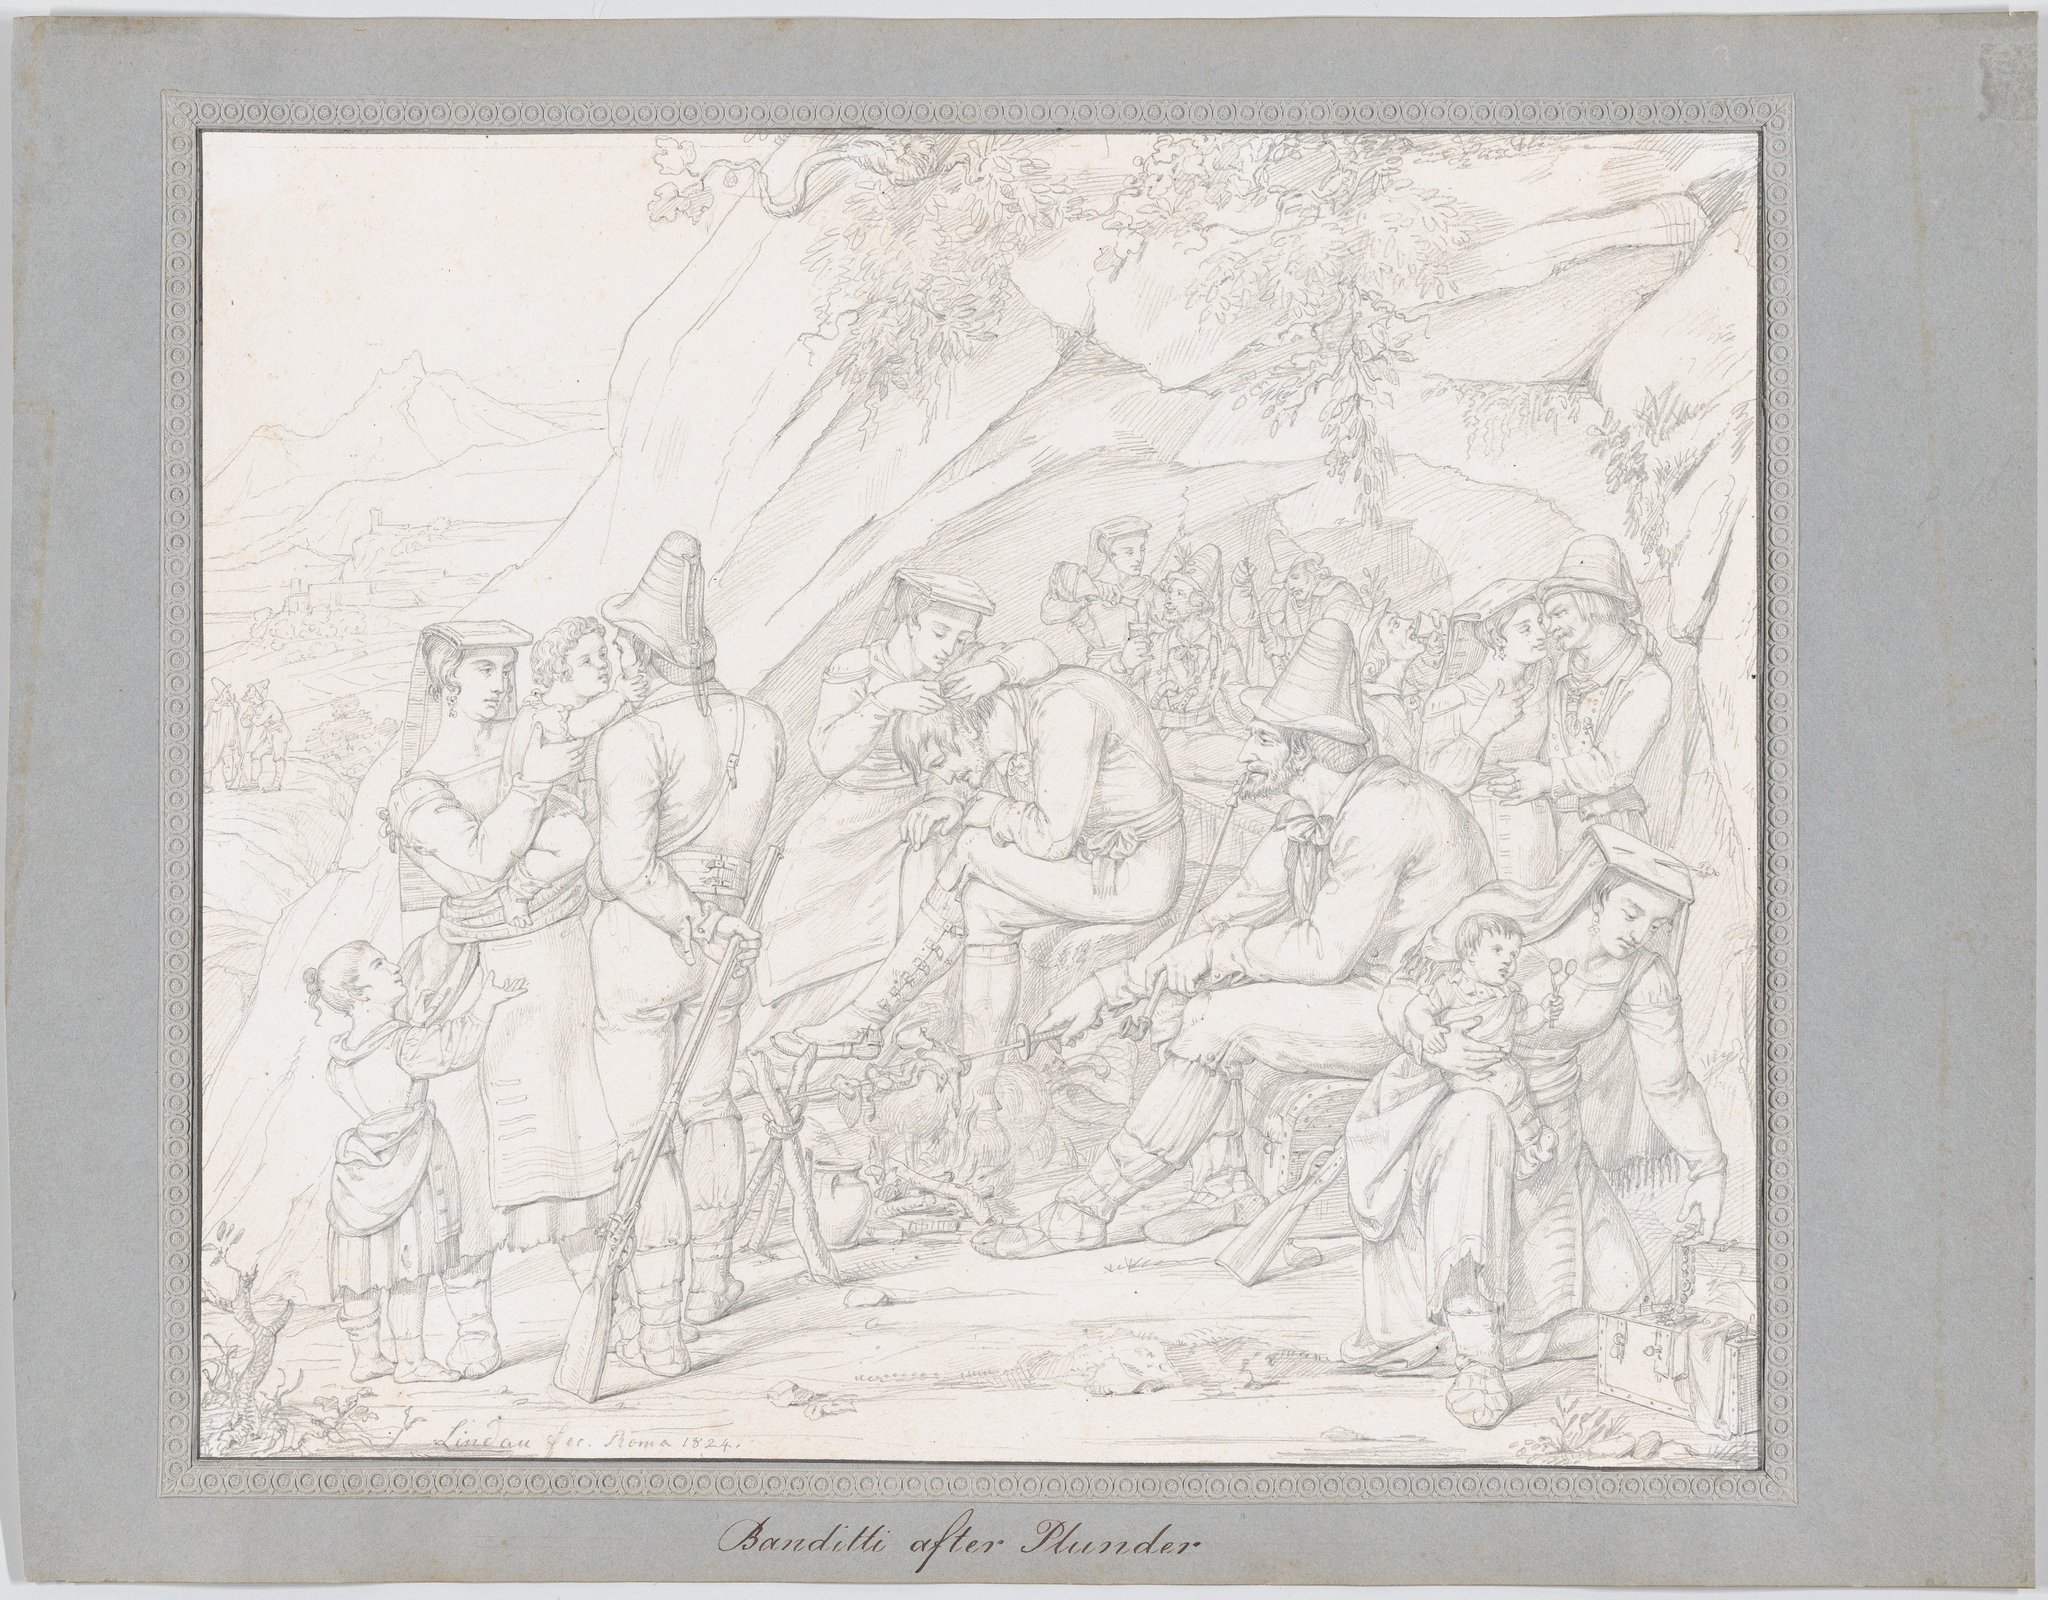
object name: drawing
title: A Group of Roman Bandits with Their Families and Companions after a Robbery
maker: dietrich wilhelm lindau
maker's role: artist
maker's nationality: german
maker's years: 1799-1862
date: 1824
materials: graphite, ink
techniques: pen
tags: firearms,infants,men,women,family